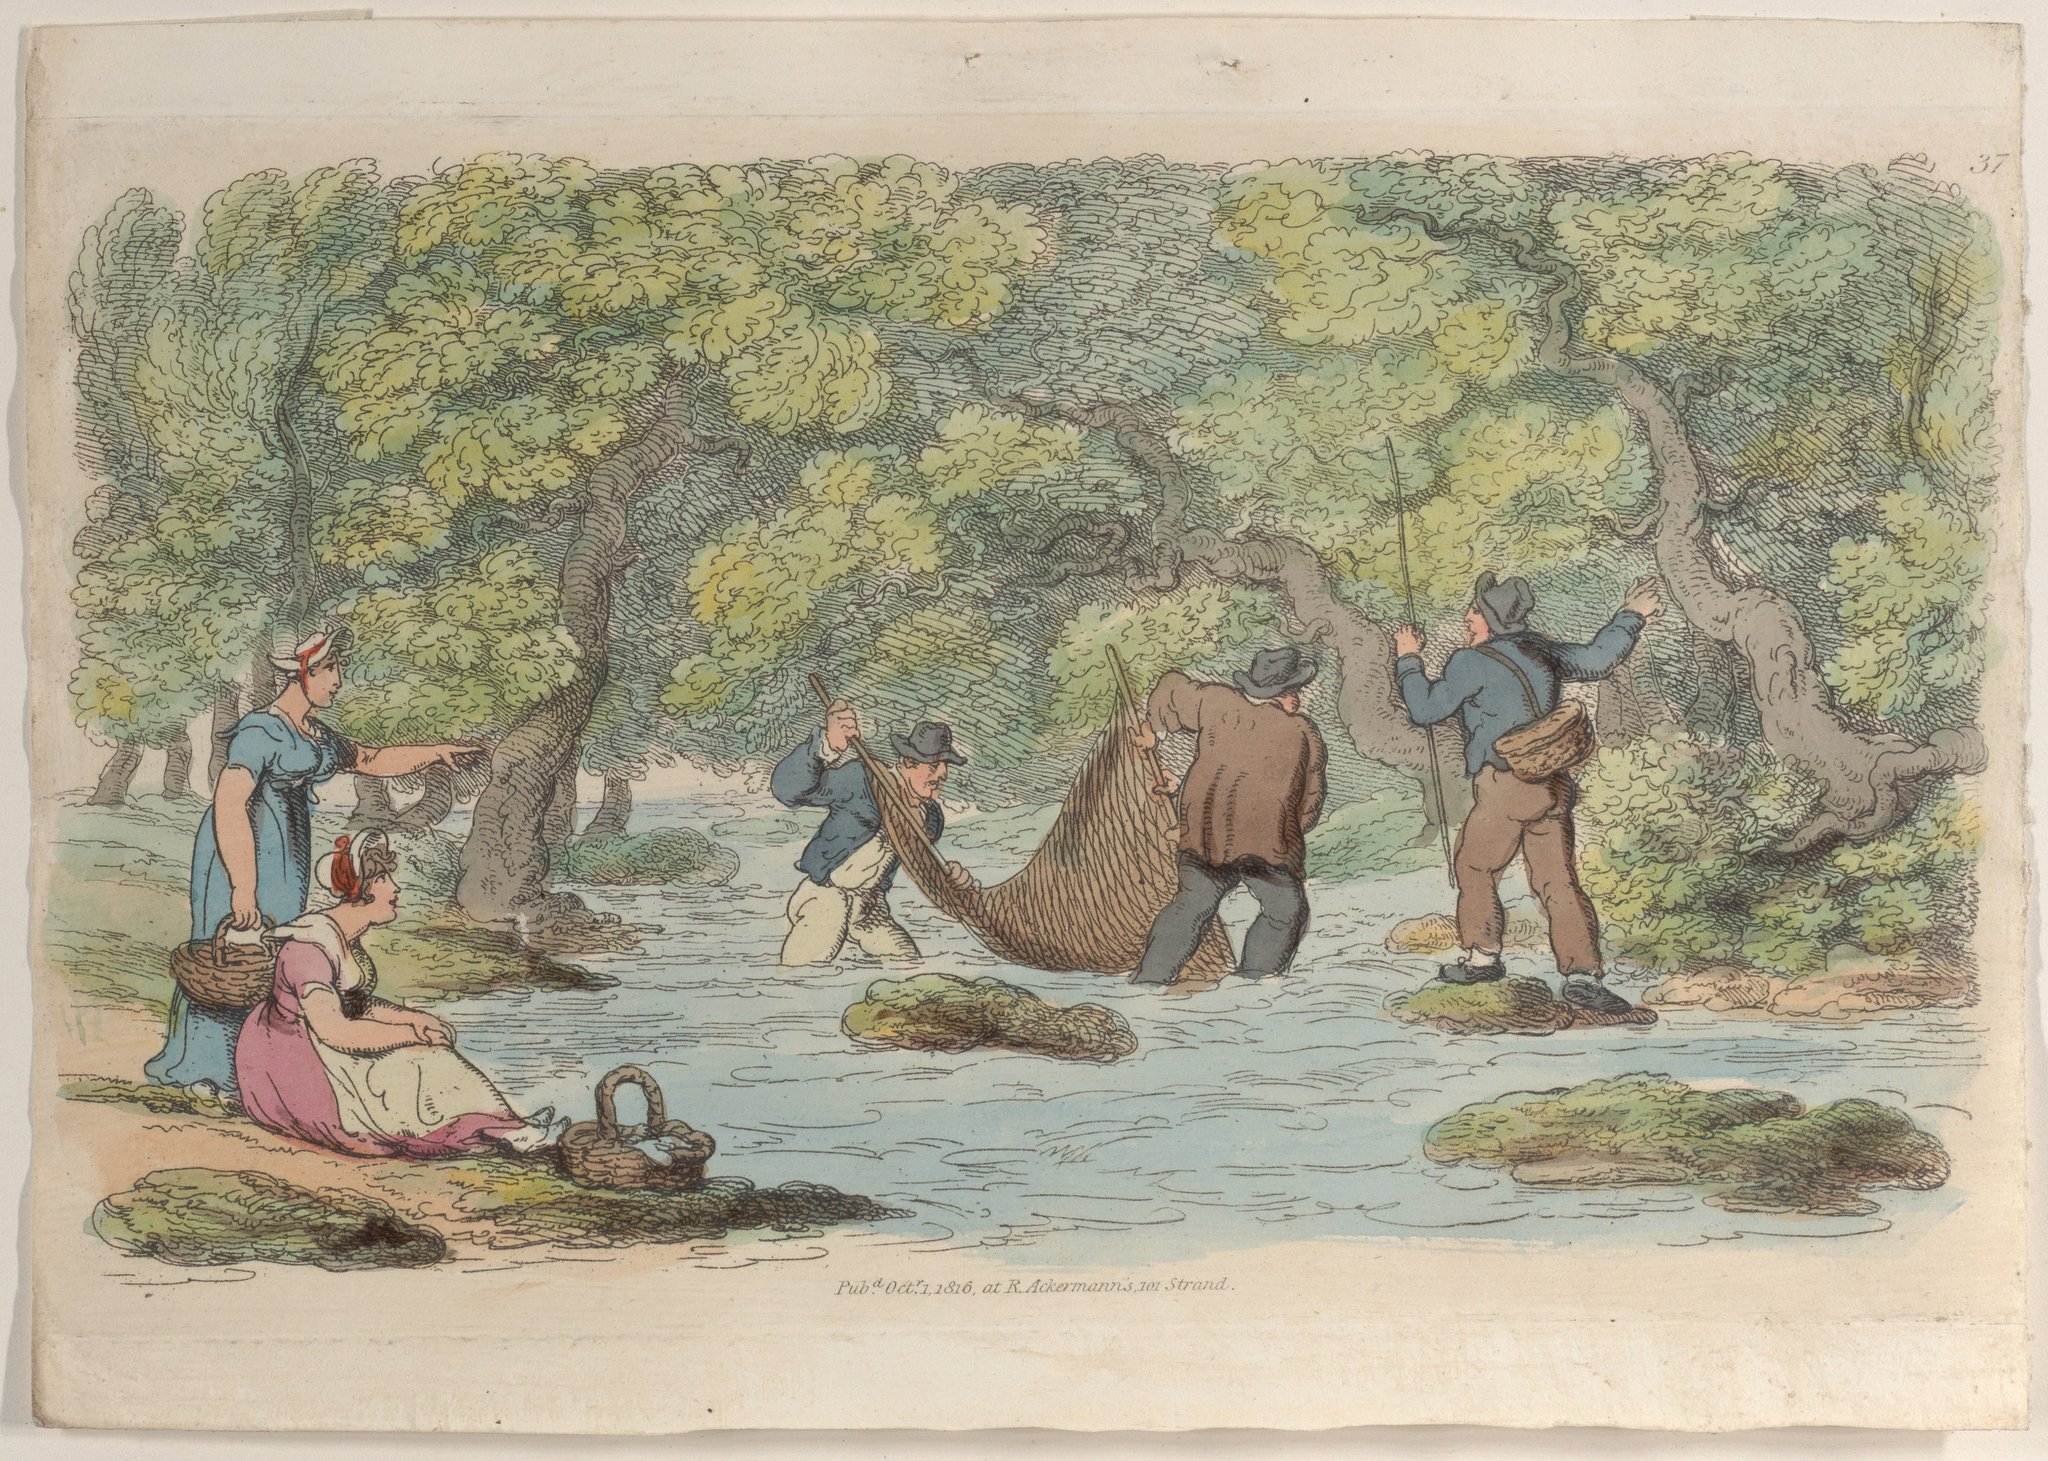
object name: print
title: Plate 37, from "World in Miniature"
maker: thomas rowlandson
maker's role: artist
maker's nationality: british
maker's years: 1757-1827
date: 1816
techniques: etching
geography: london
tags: men,women,fishing,rivers